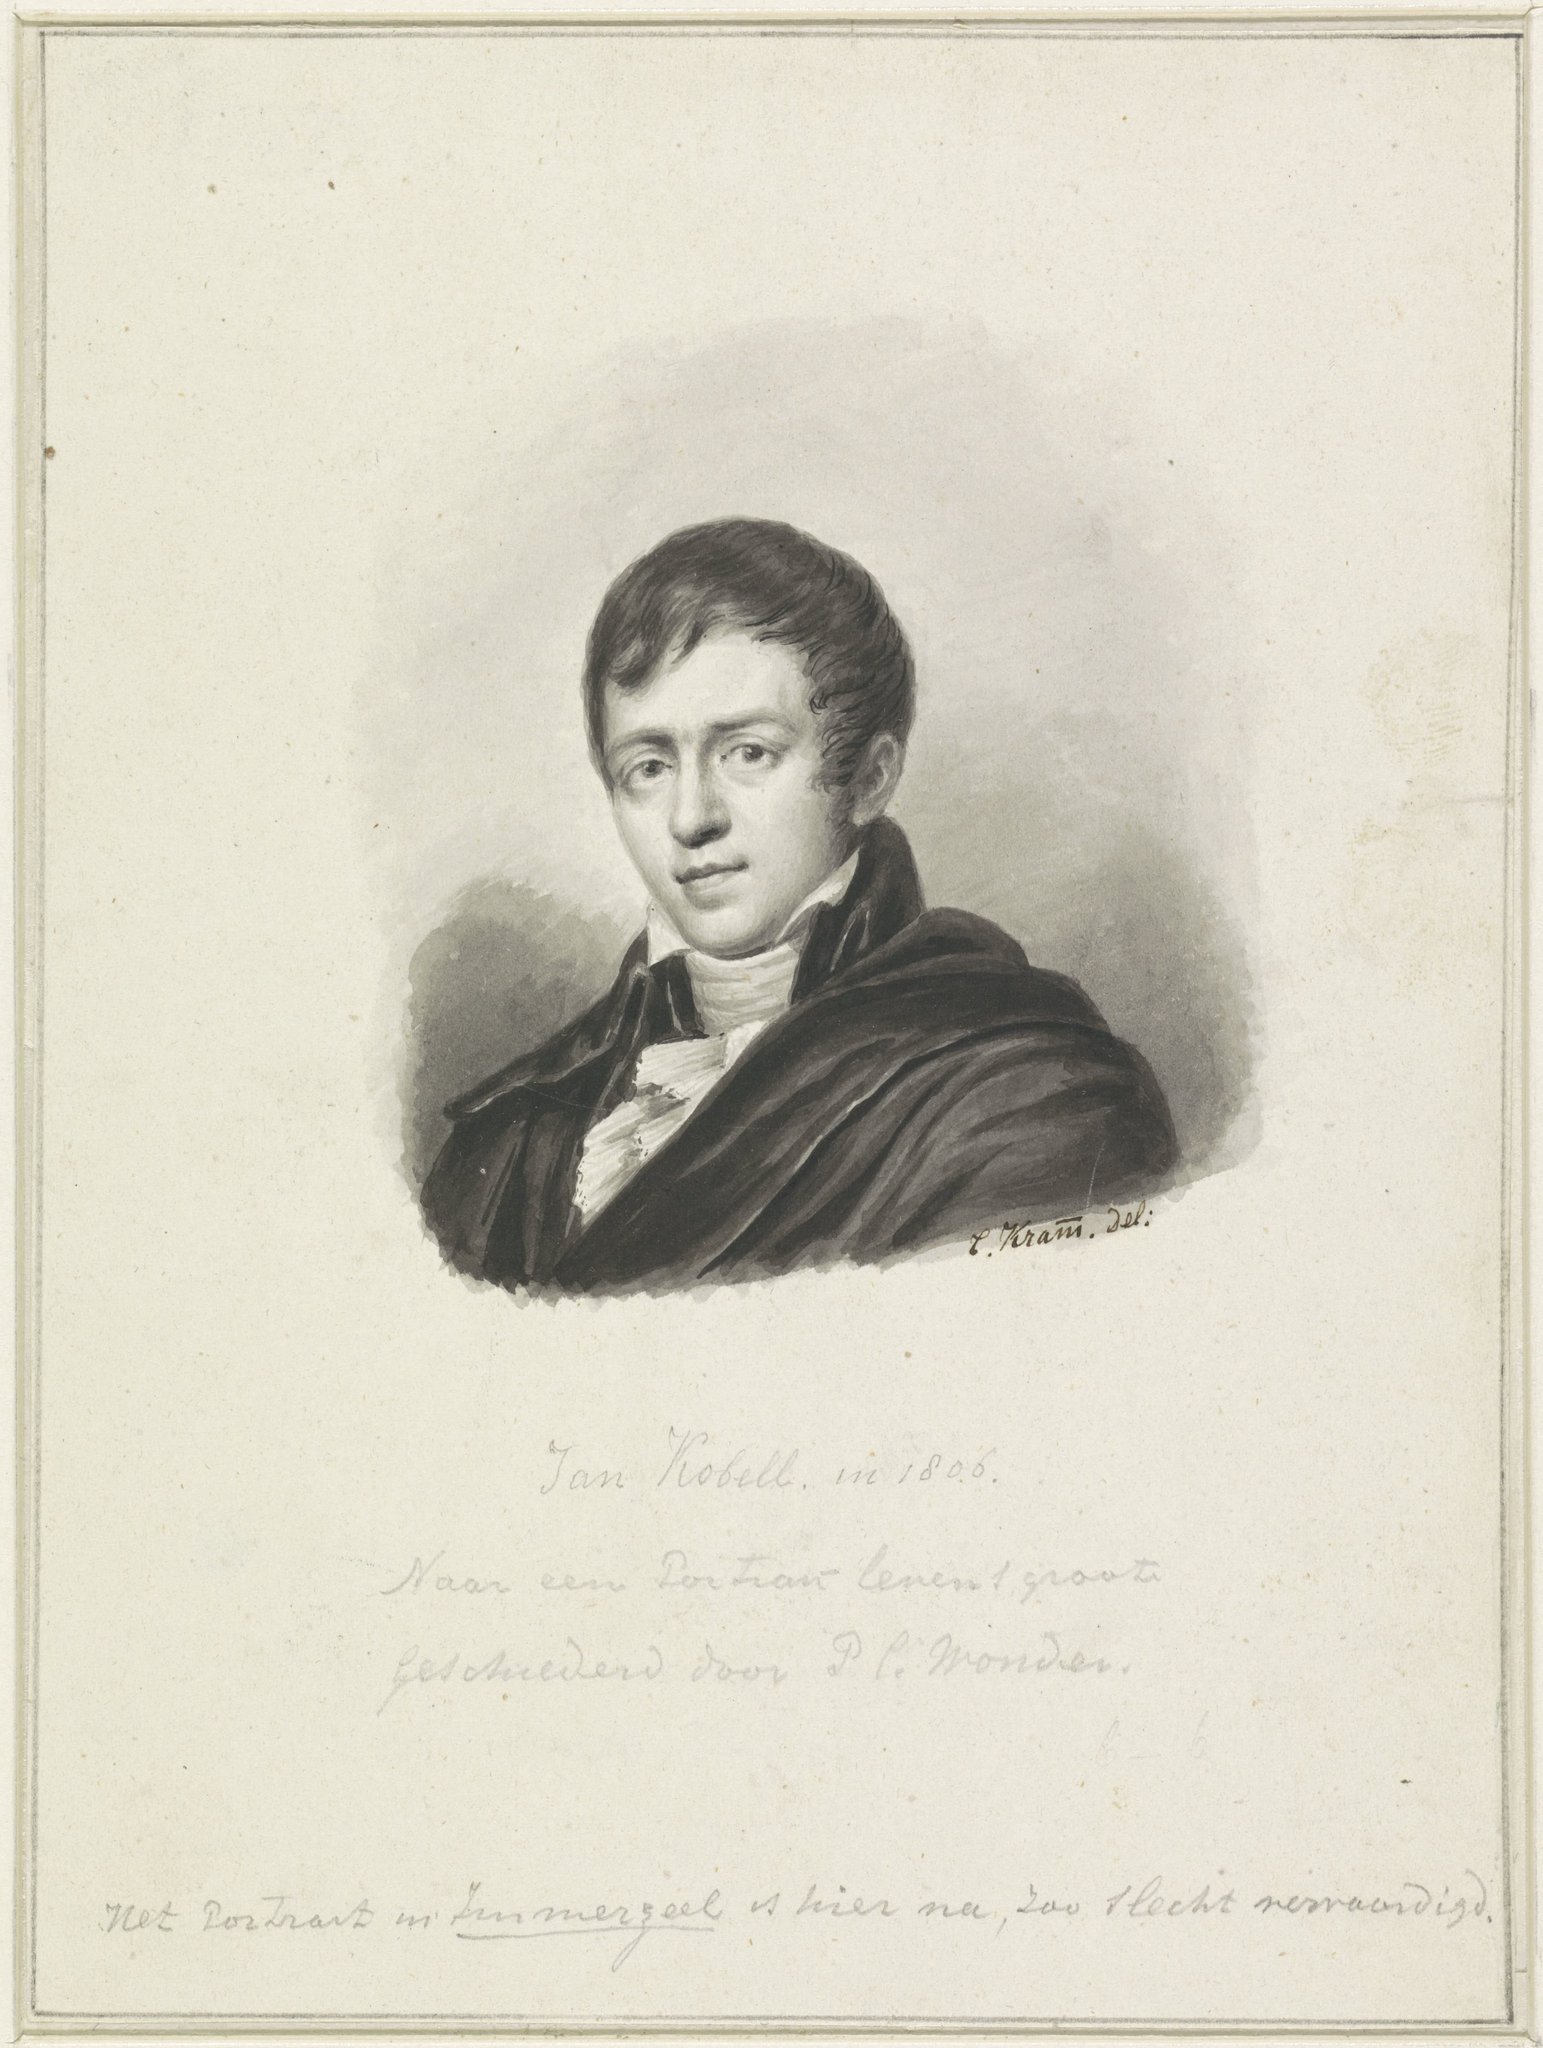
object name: drawing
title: Portret van Jan Kobell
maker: christiaan kramm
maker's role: draughtsman, print maker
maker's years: 1797-1875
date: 1807-1875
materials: paper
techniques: brush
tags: jan kobell, historical persons, portrait, self-portrait of artist